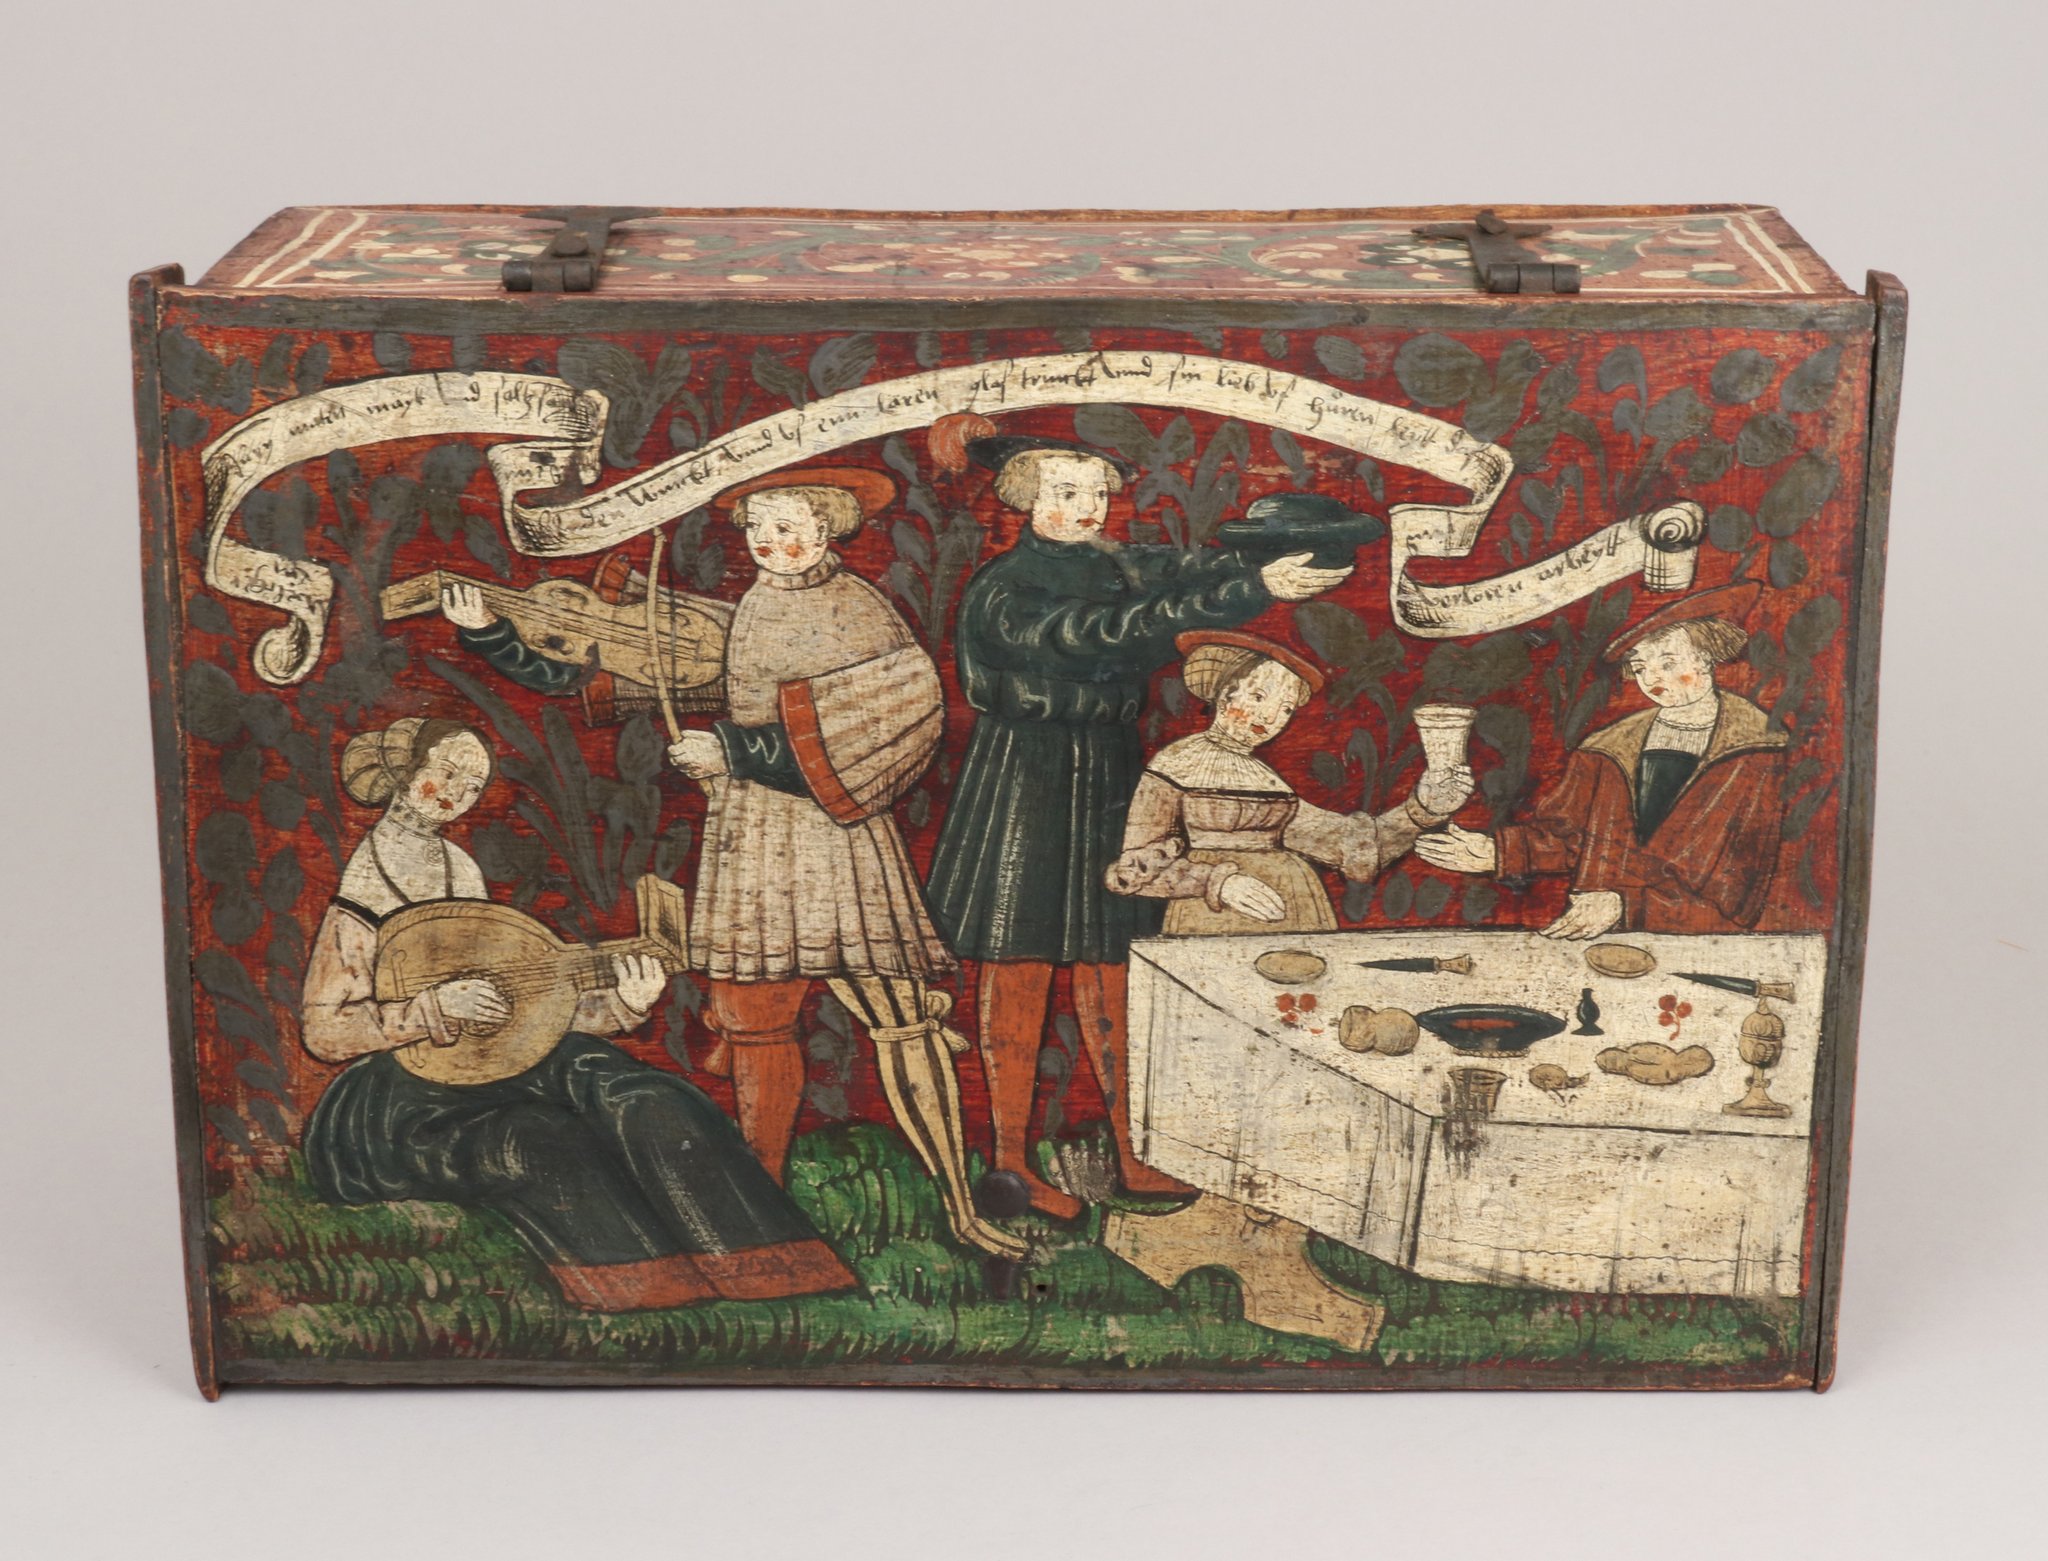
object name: box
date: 1501-1600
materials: wood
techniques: painting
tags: men,women,lutes,drinking